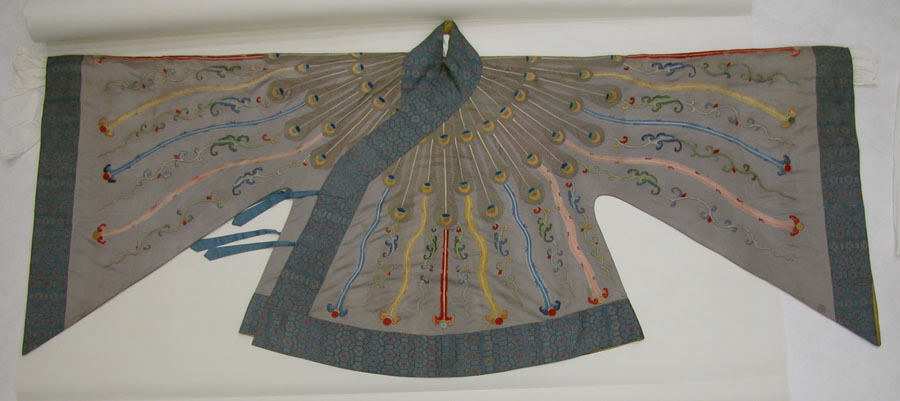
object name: jacket, imperial theatrical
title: Theatrical jacket with peacock feather design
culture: chinese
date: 1701-1800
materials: metal thread, silk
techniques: brocade, embroidery